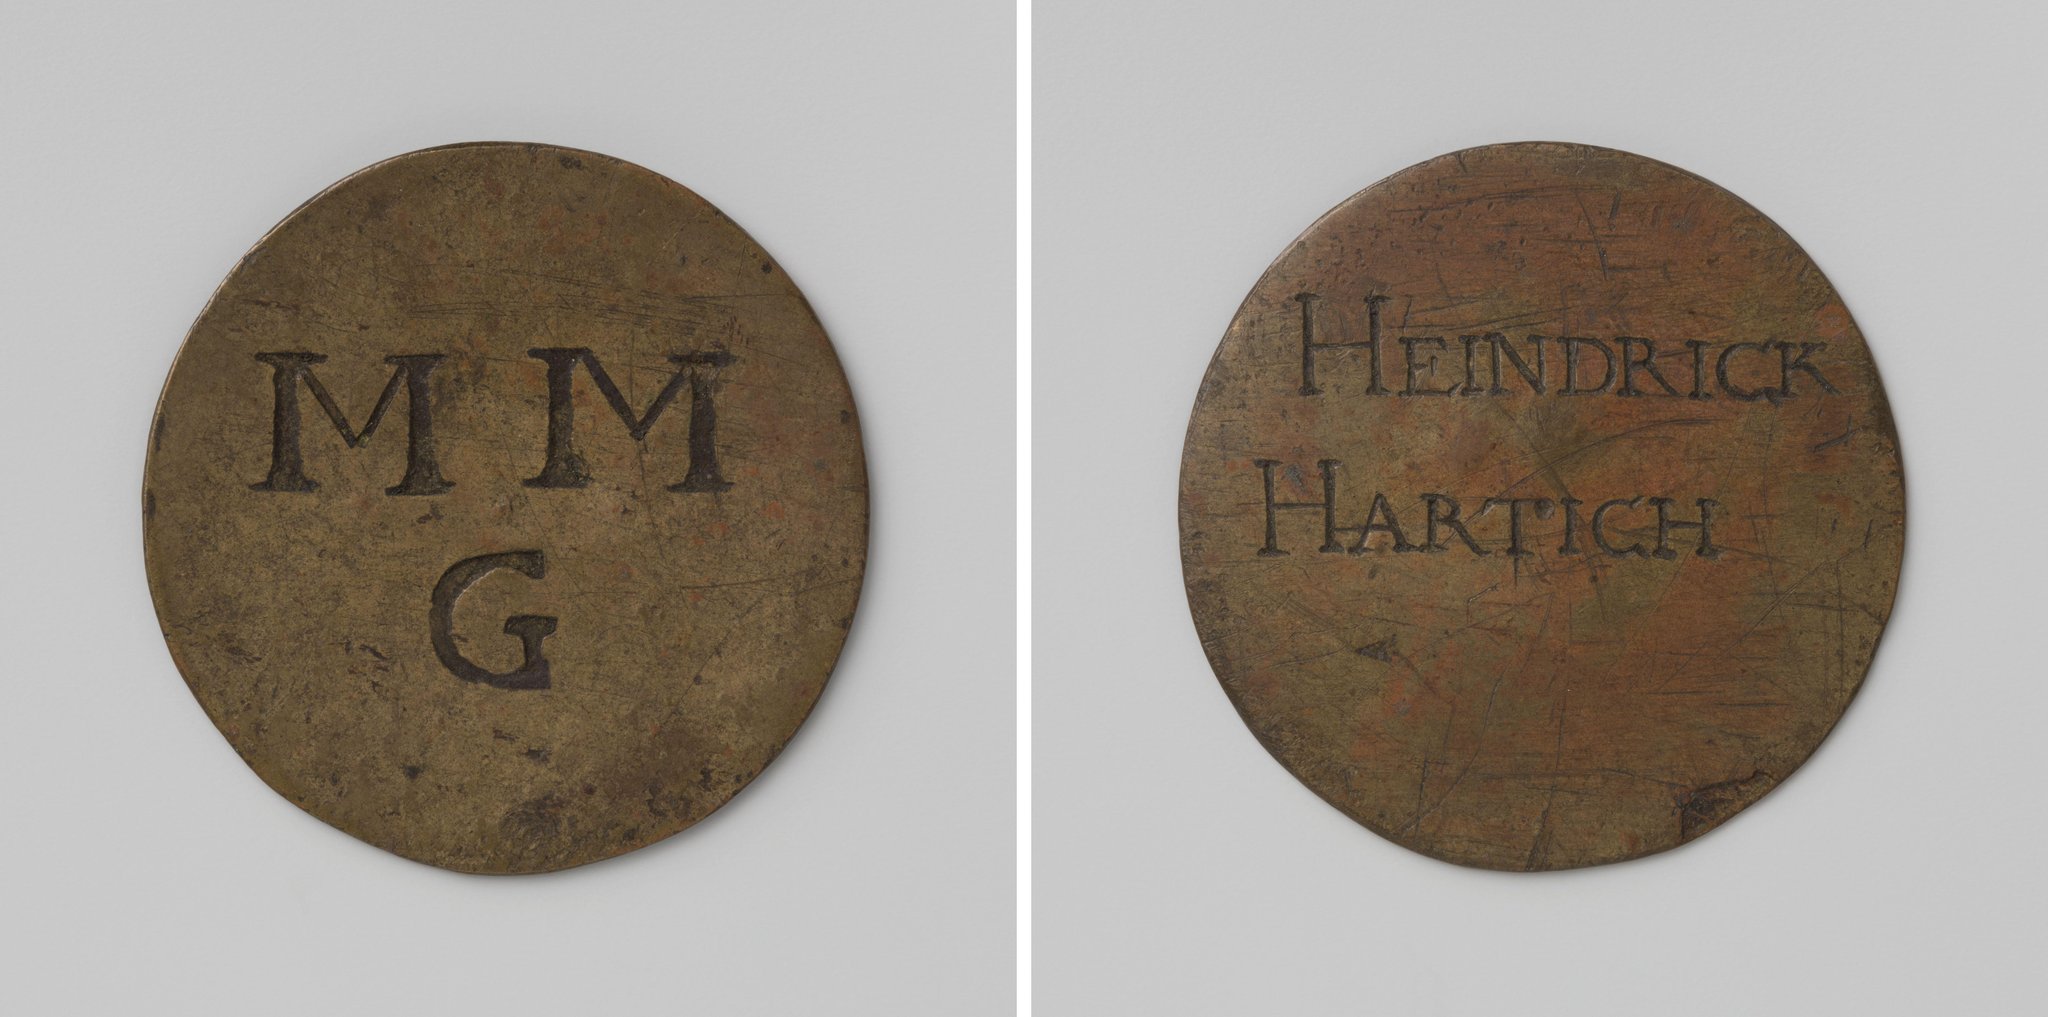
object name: medal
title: Mandemakersgilde van Amsterdam, gildepenning van Heindrick Hartich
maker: Anonymous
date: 1624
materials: brass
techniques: engraving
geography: amsterdam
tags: amsterdam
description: Messing penning. Voorzijde: opschrift. Keerzijde: twee letters M boven letter G